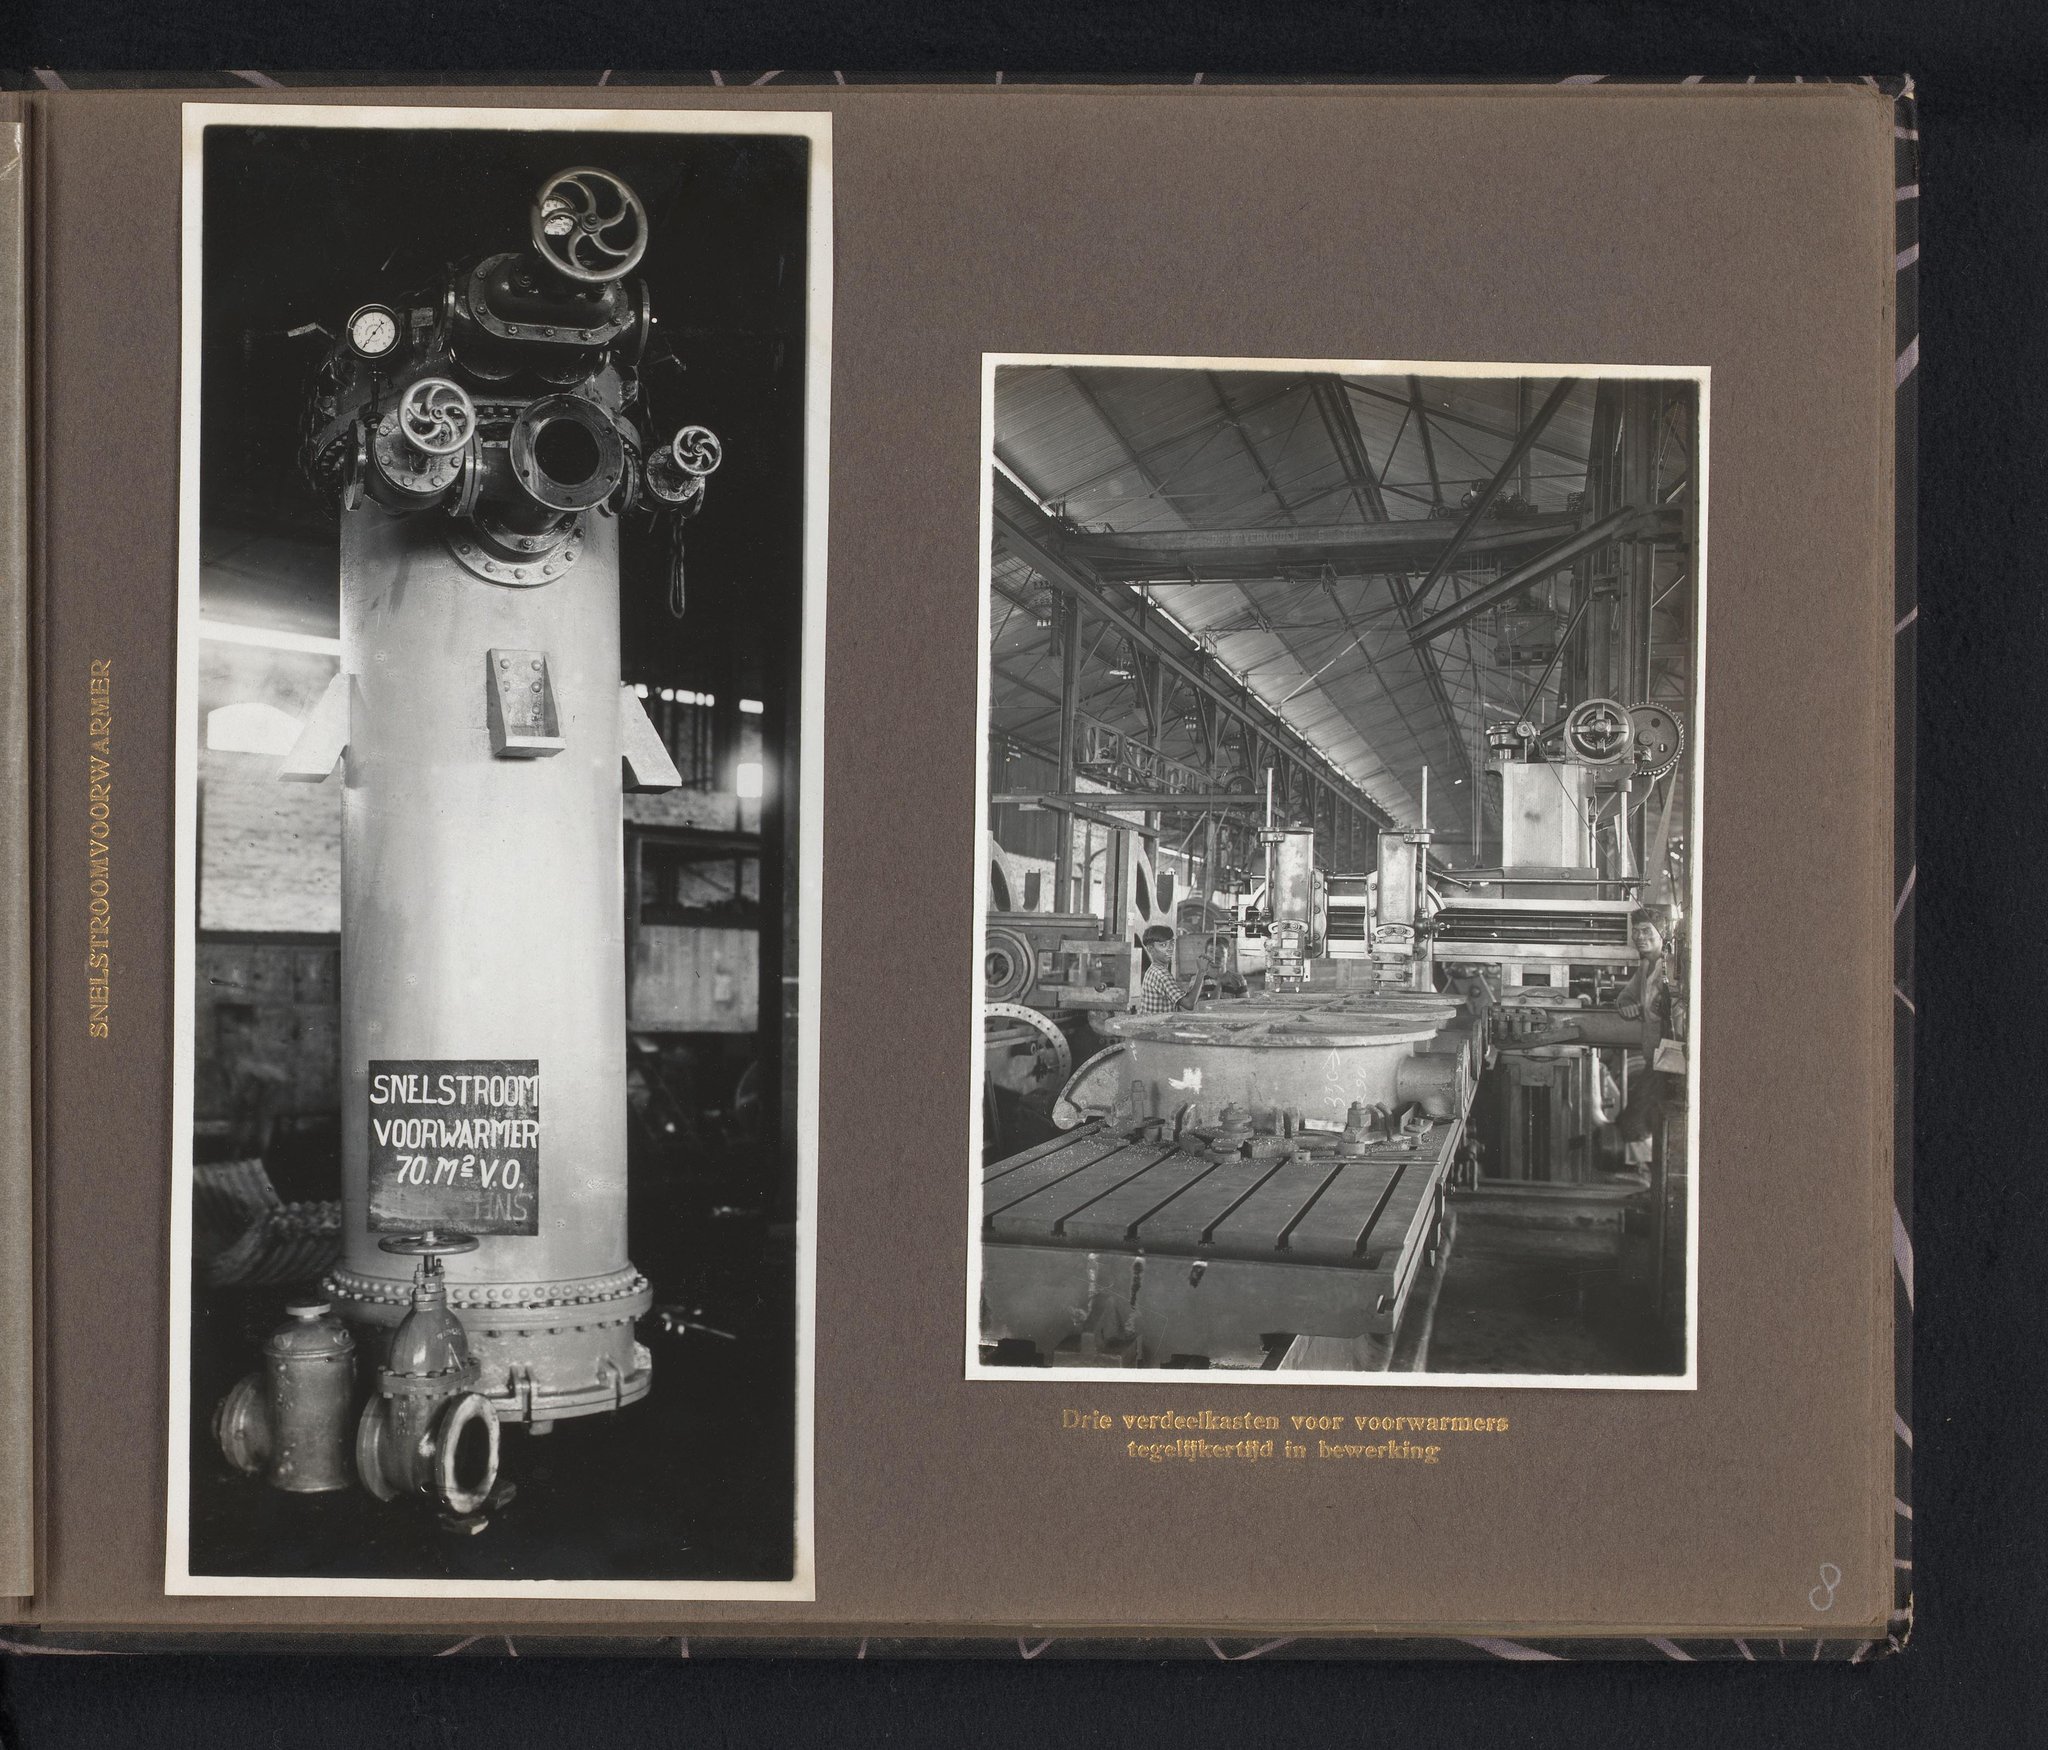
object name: album leaf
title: Snelstroomvoorwarmer / Drie verdeelkasten voor voorwarmers tegelijkertijd in bewerking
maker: Anonymous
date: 1916-1924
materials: cardboard, photographic support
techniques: gelatin silver print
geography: surabaya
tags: colonial system, factory-interior, machine shop, machines; parts of machines; tools and appliances, java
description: Albumblad met twee foto's van machines. Vervaardigd door Machinefabriek Braat. Onderdeel van het fotoalbum Machinefabriek Braat Soerabaia-Djocja-Tegal, ca. 1916-1924.